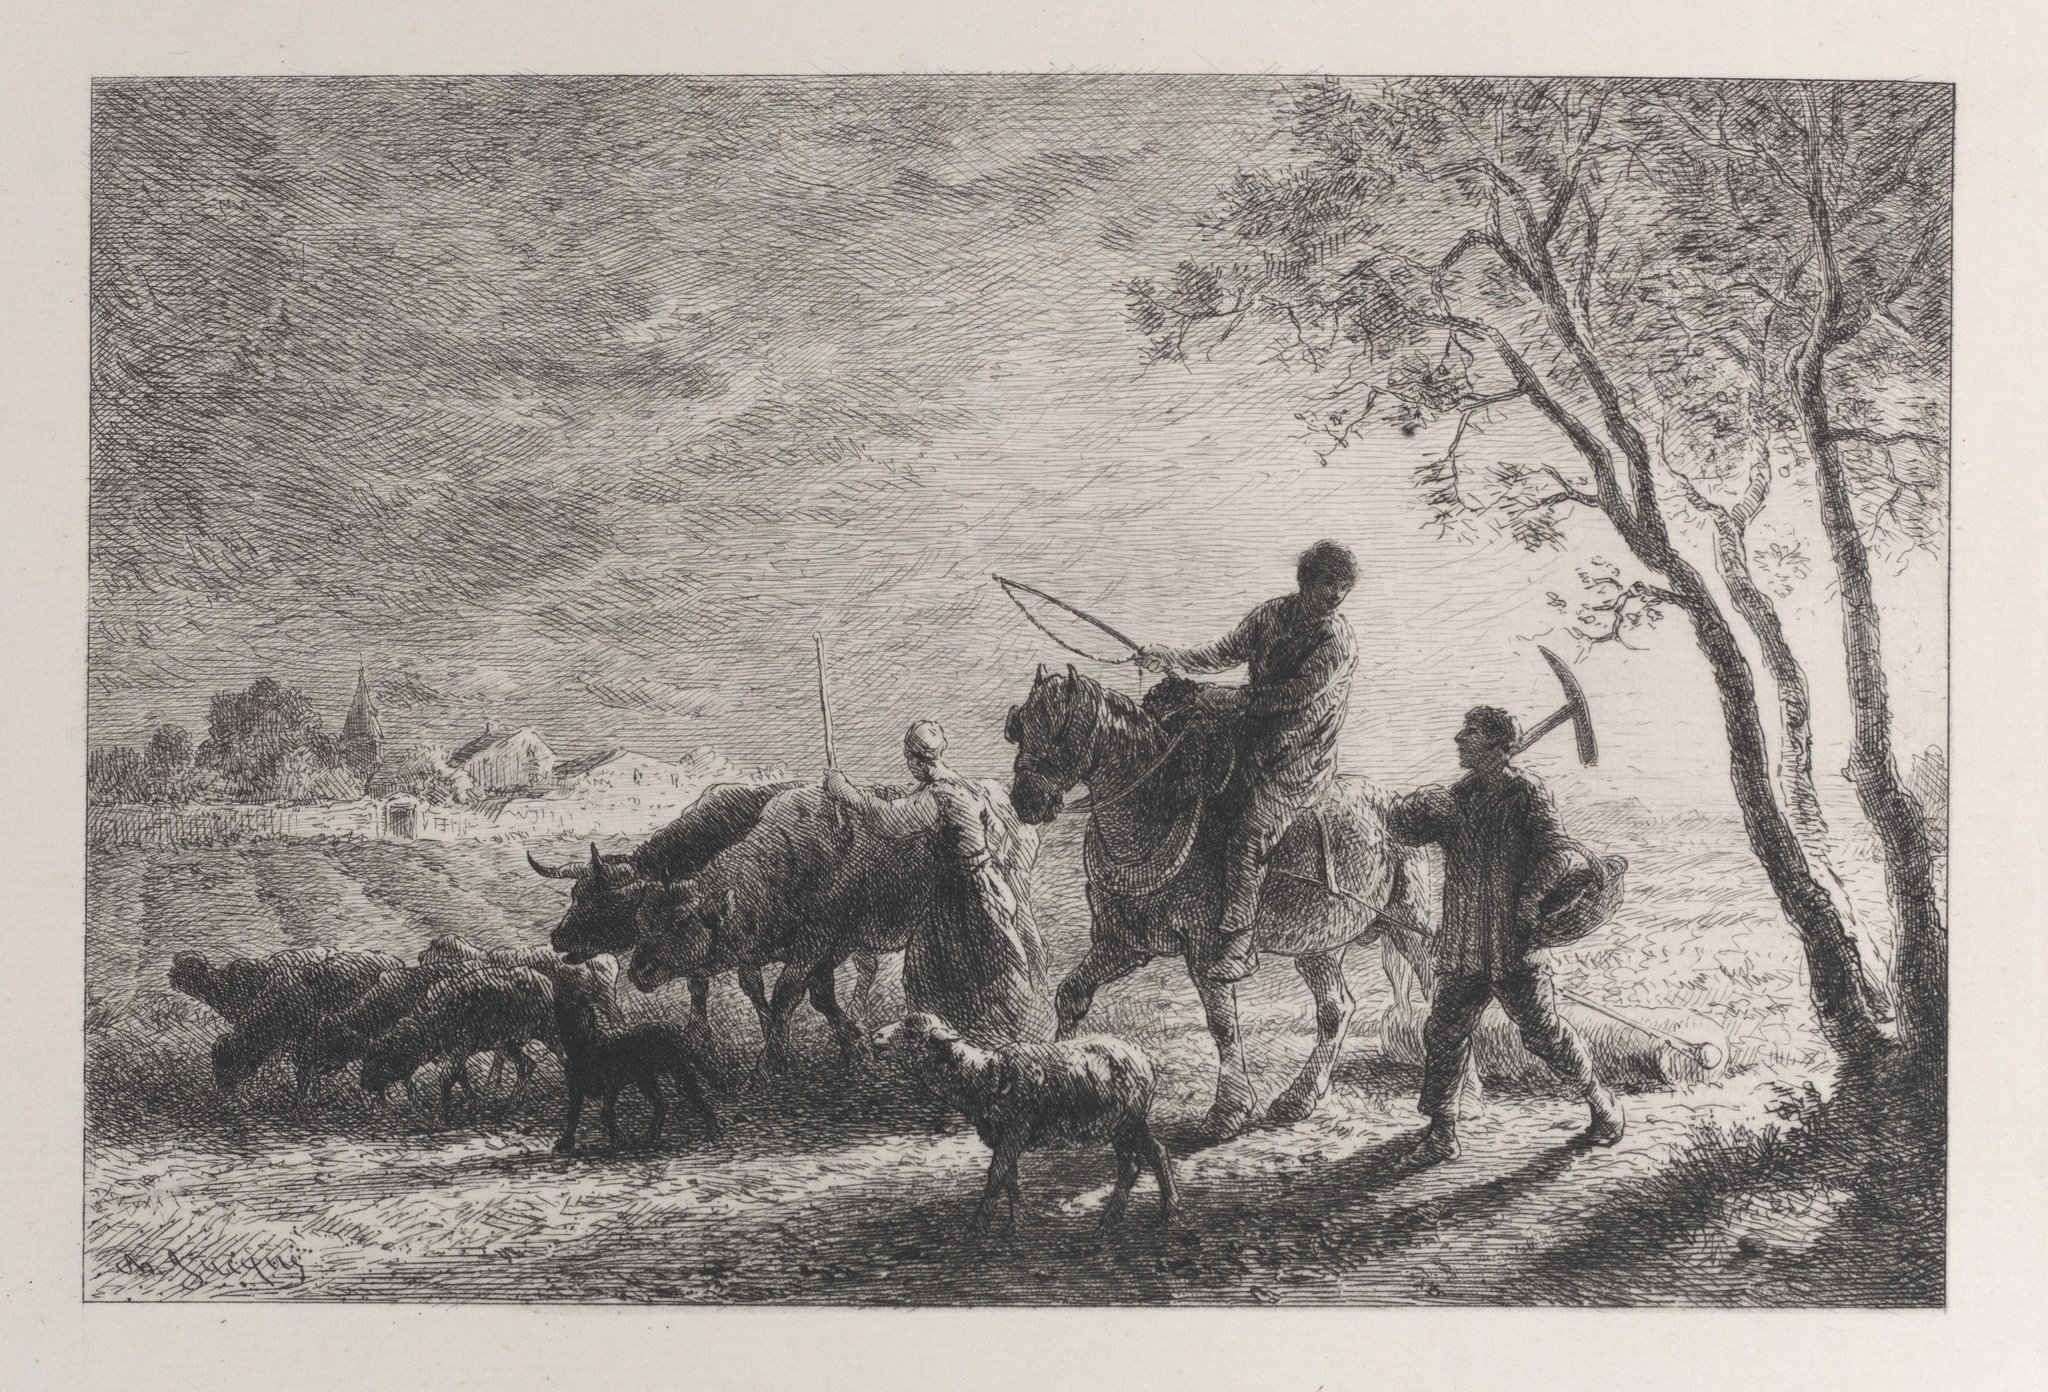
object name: print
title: The Return from the Fields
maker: charles émile jacque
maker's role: artist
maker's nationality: french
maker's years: 1813-1894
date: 1865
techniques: etching